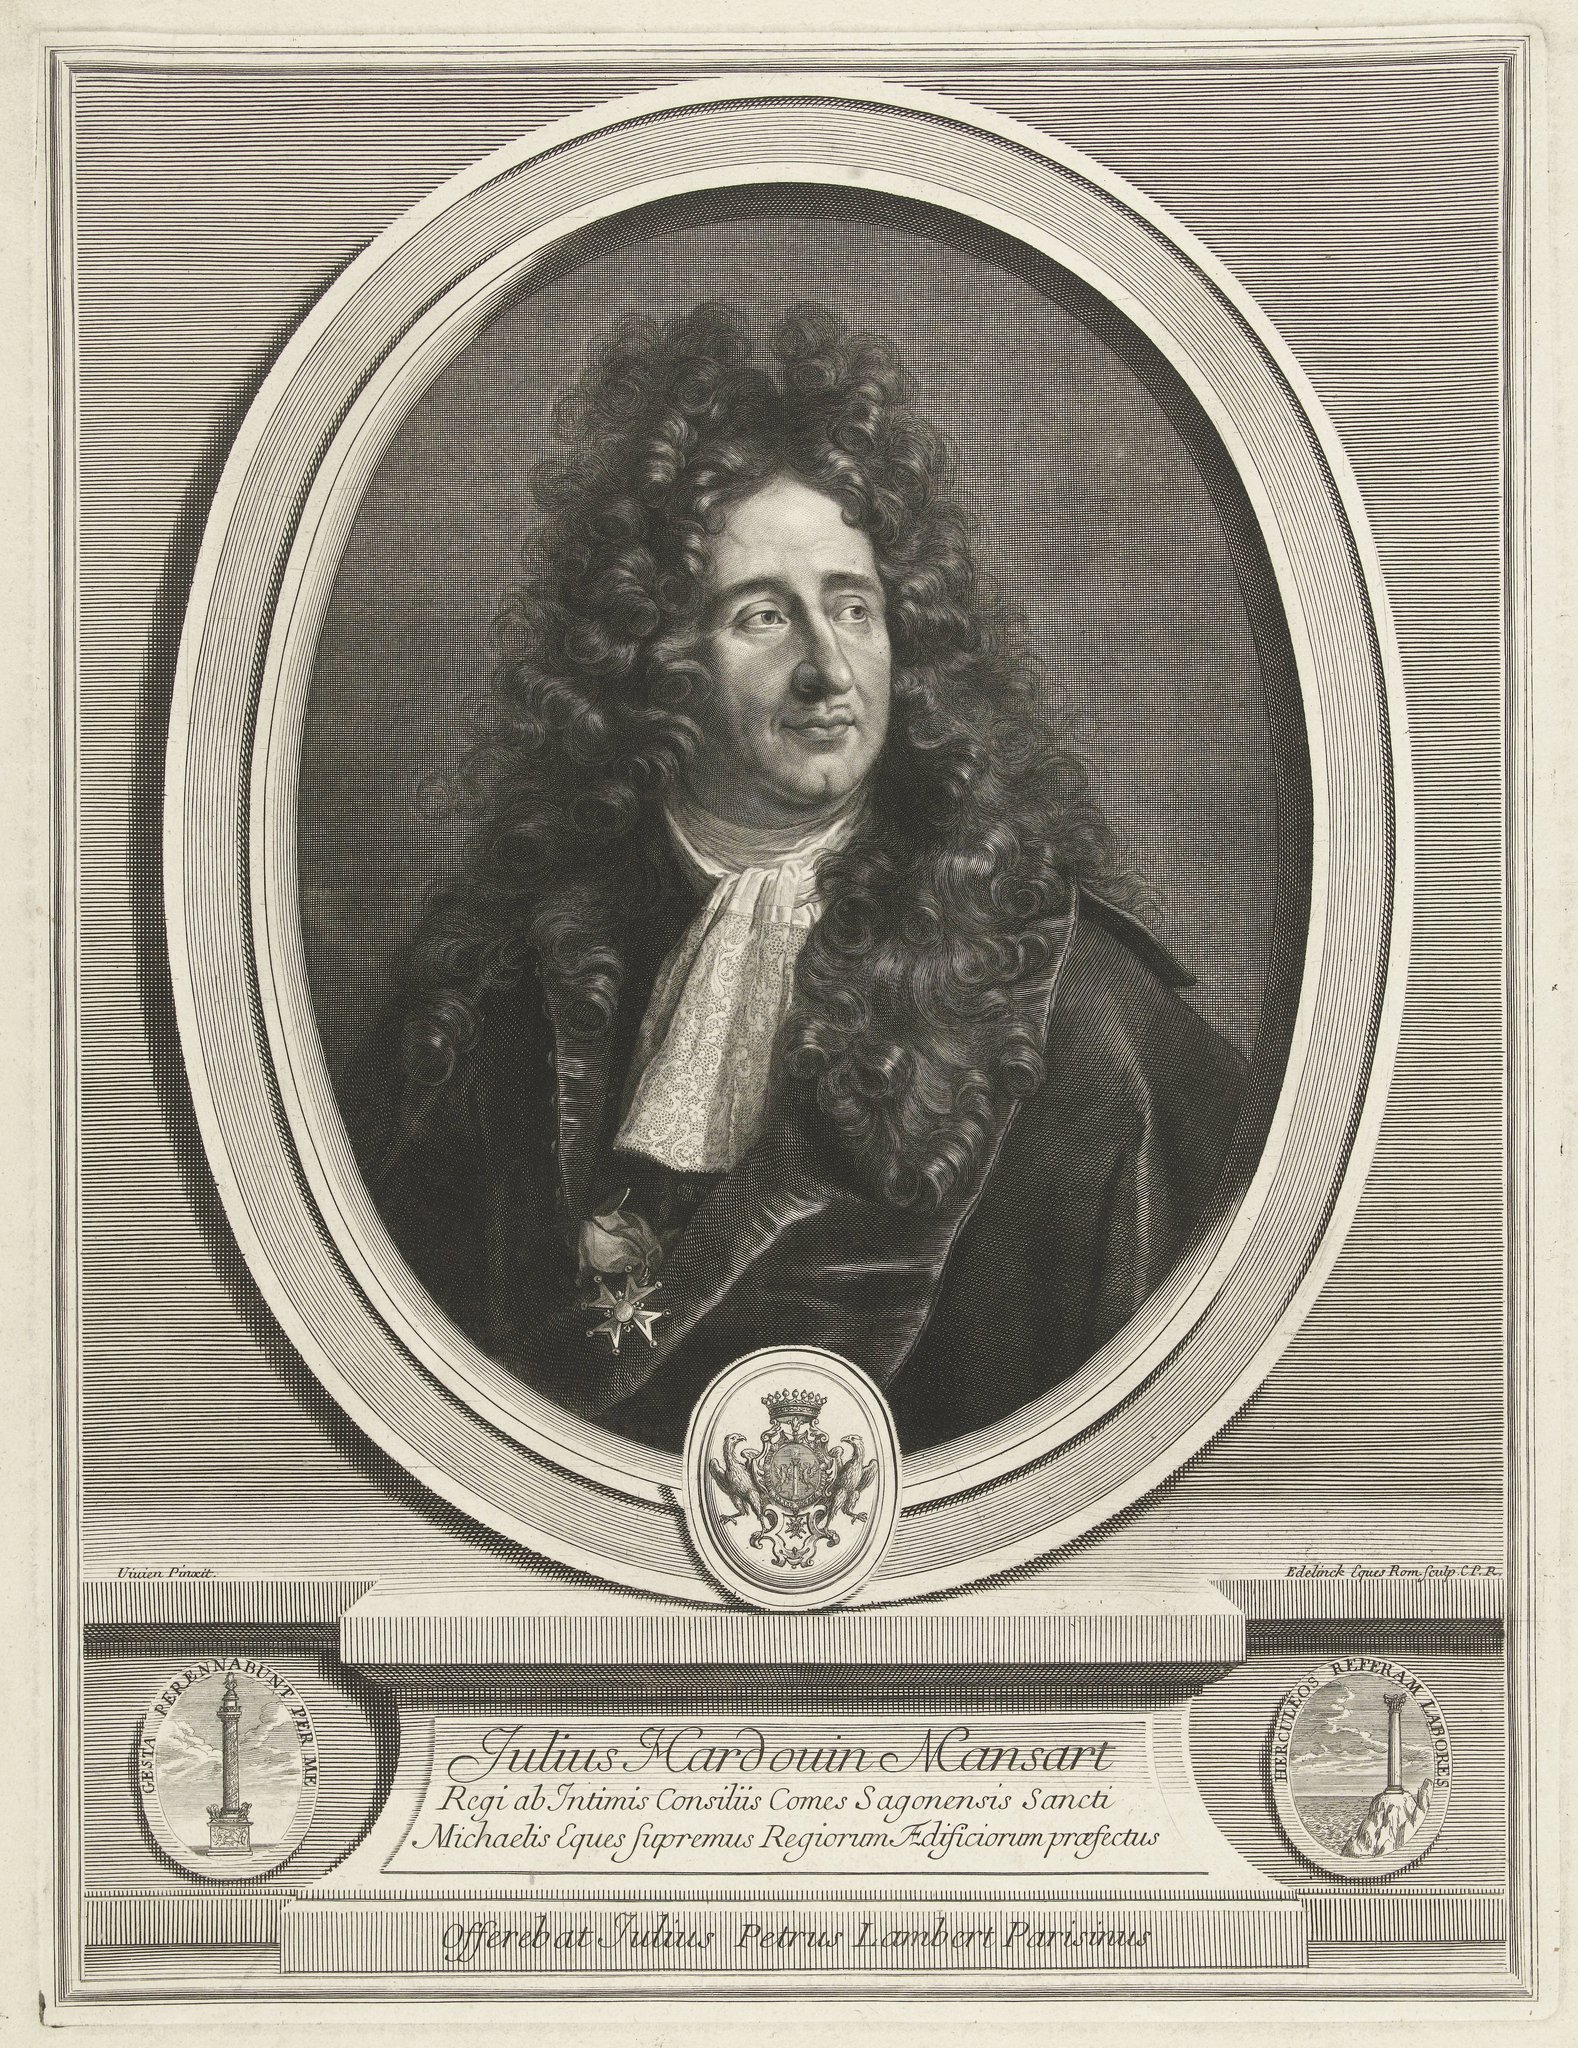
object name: print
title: Julius Hardouin Mansart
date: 1666-1707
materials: paper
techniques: engraving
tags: paris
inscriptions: collector's mark: Lugt 240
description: Portret van Franse architect Jules Hardouin-Mansart (1646-1708), afgebeeld in ovale omlijsting met wapen. Onder de lijst een console met drie regels tekst in Latijn en aan weerszijden een ovaal embleem.